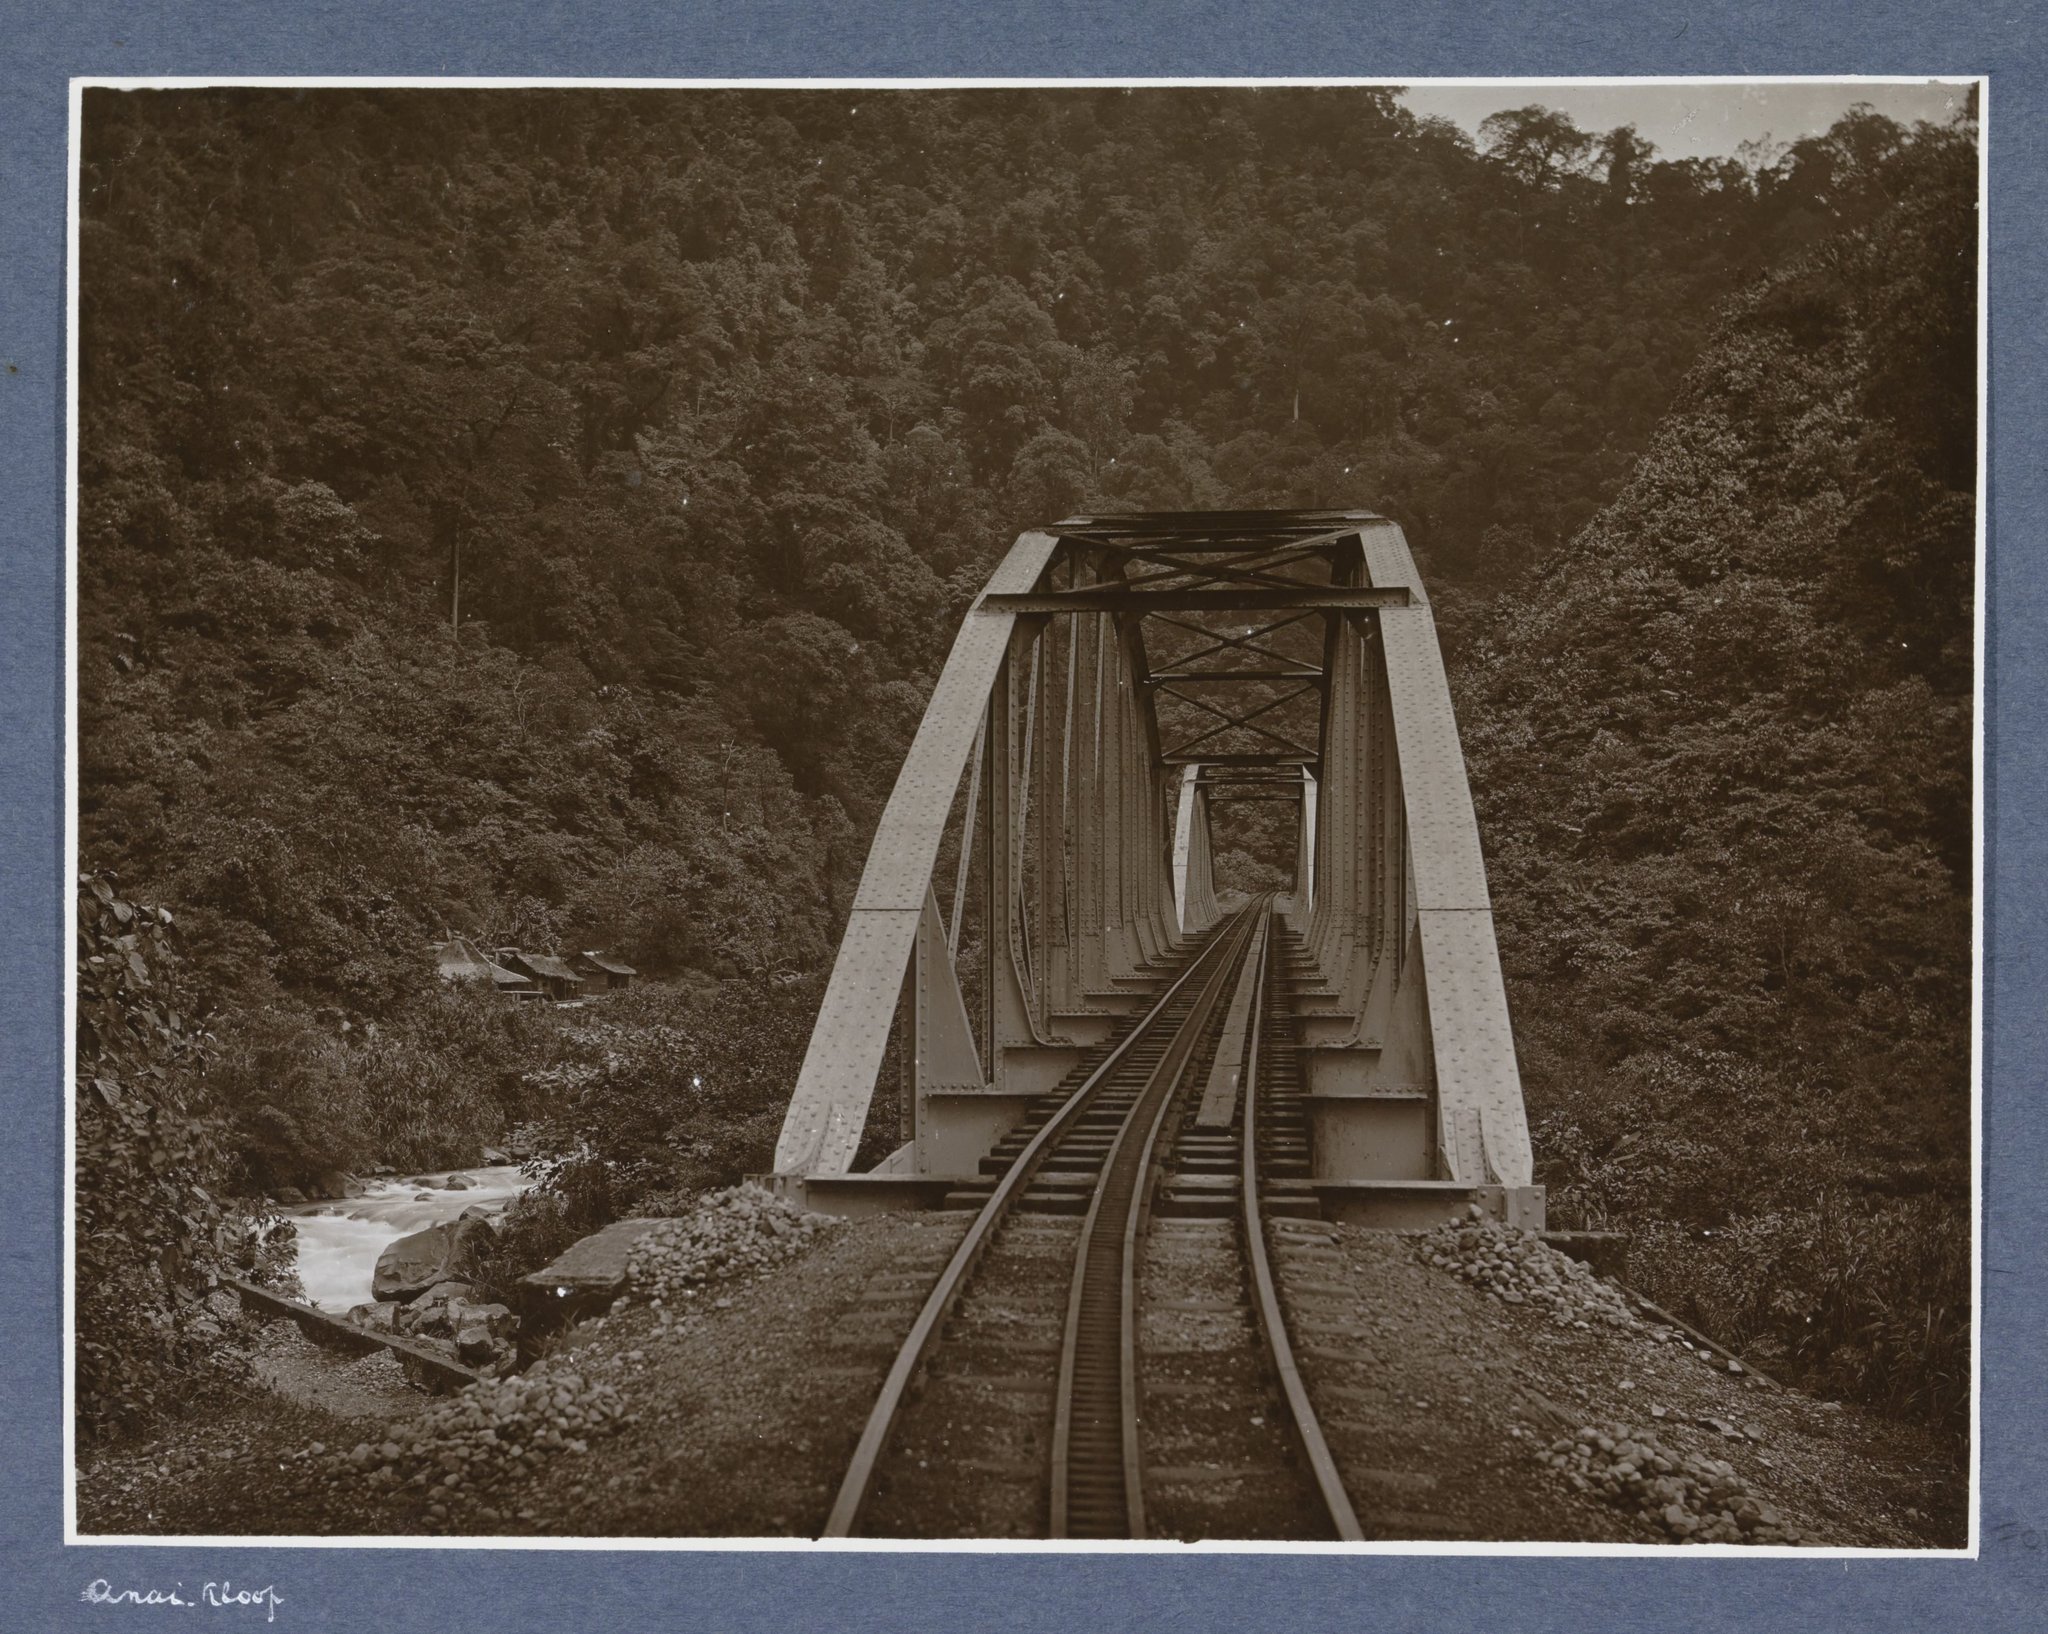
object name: photograph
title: Spoorbrug met tandradspoorbaan in de Anaikloof op Sumatra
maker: christiaan benjamin nieuwenhuis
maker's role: publisher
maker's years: 1863-1922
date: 1900-1920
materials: paper, photographic support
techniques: gelatin silver print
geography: sumatra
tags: funicular railway, ravine, chasm, abyss, canyon, railway, train, sumatra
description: Onderdeel van reisalbum met foto's van bedrijvigheid en bezienswaardigheden op Sumatra en Java en van de reis naar en van Nederlands-Indië.